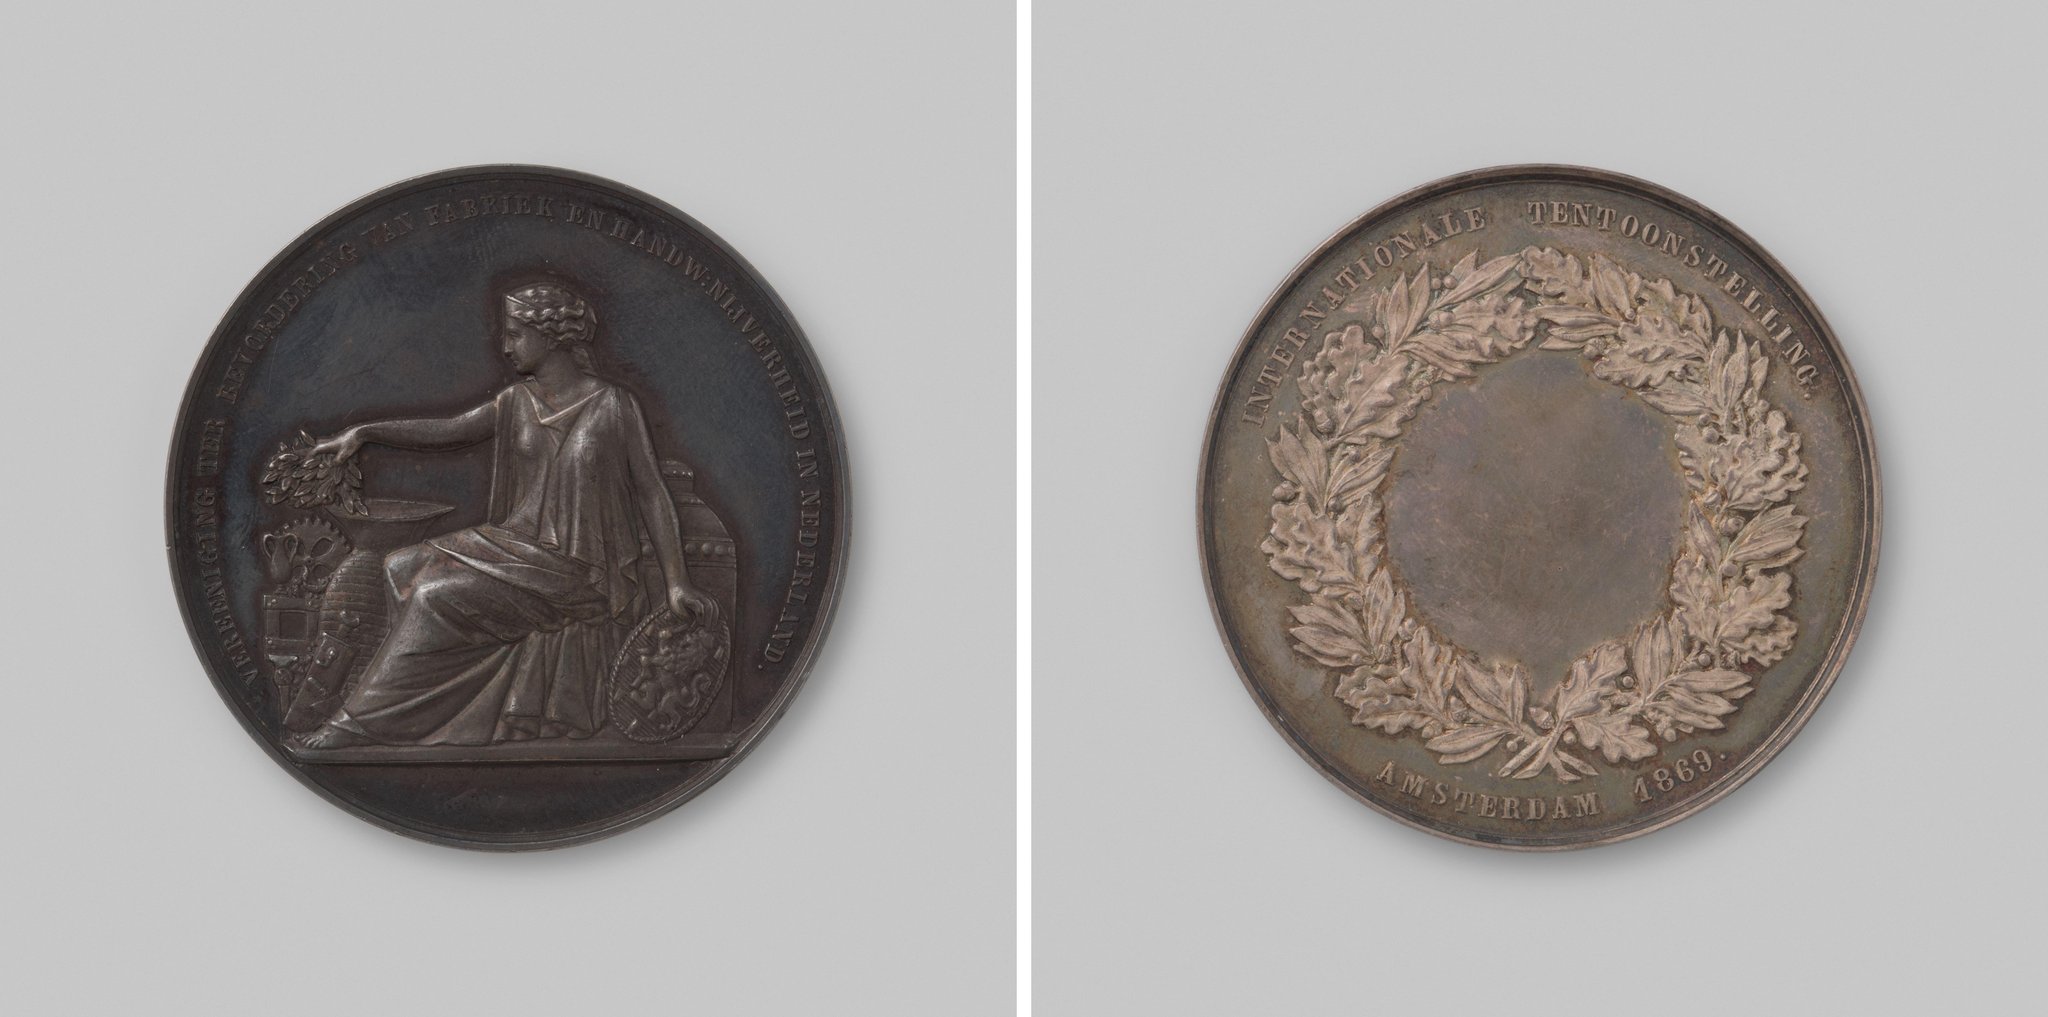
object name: medal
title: Internationale tentoonstelling van voorwerpen voor de huishouding en het bedrijf van de handwerksman te Amsterdam, penning uitgereikt door de Vereeniging ter bevordering van Fabrijk- en Handwerksnijverheid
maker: Anonymous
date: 1869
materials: silver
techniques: striking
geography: netherlands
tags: amsterdam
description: Zilveren penning. Voorzijde: vrouw met diadeem in haar, houdt in rechterhand lauwerbladeren en in linkerhand wapenschild; rondom haar voorwerpen van industrie en nijverheid binnen omschrift. Keerzijde: blanco veld binnen eikekrans en omschrift.